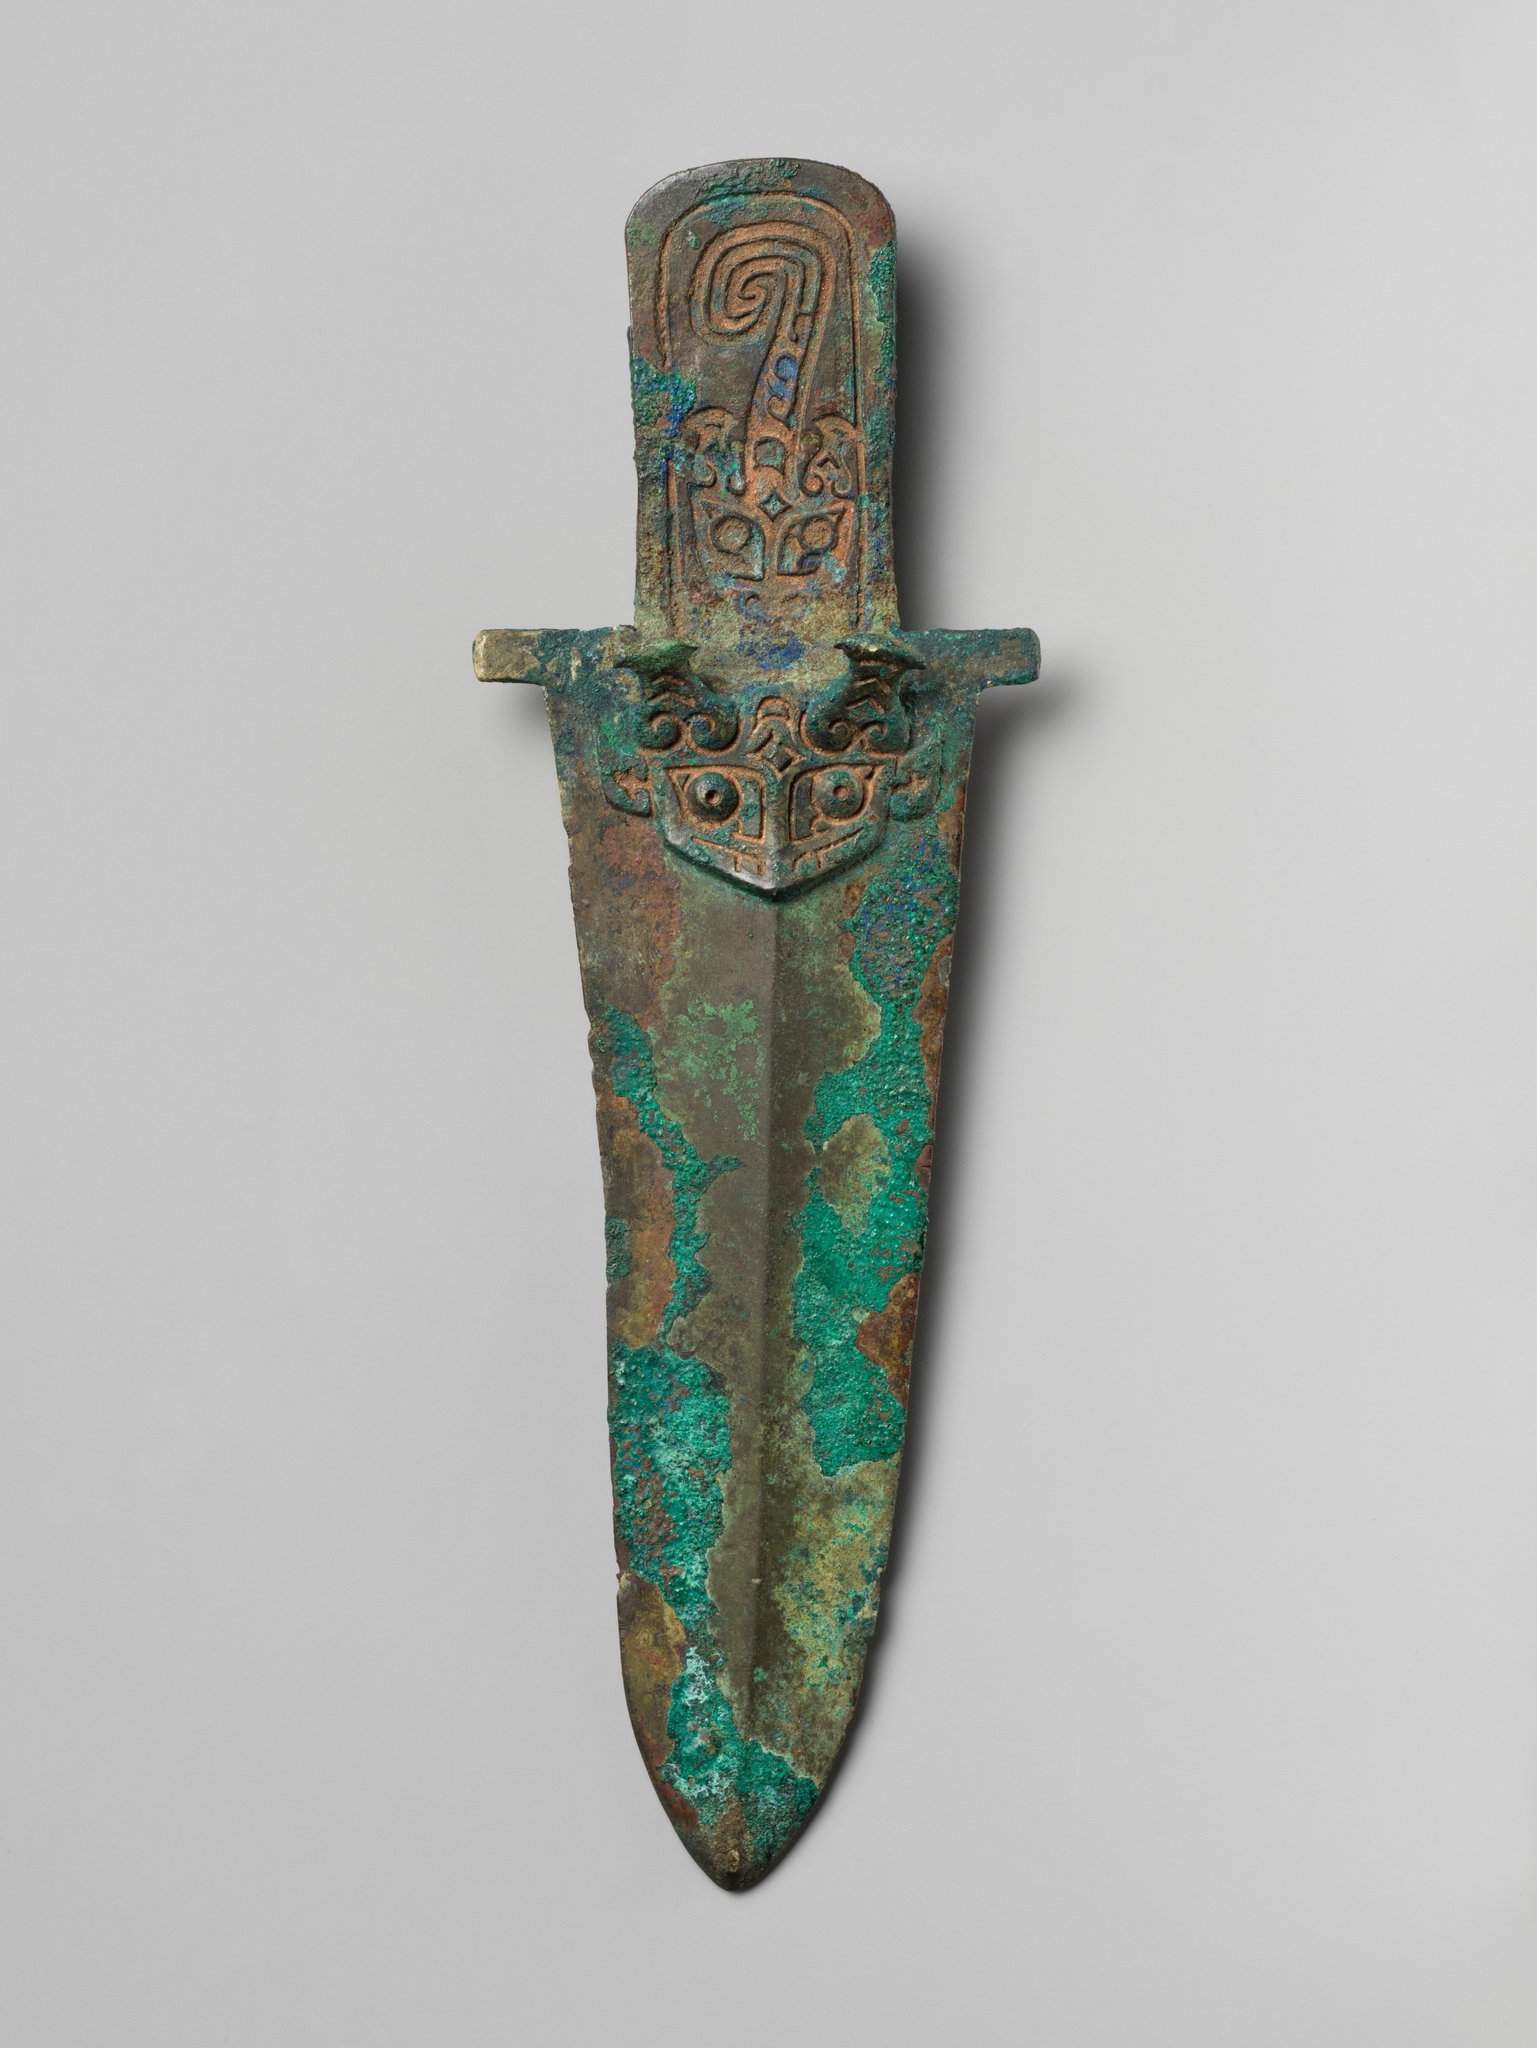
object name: dagger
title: Dagger-Axe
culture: chinese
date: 1100-901 BCE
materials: bronze